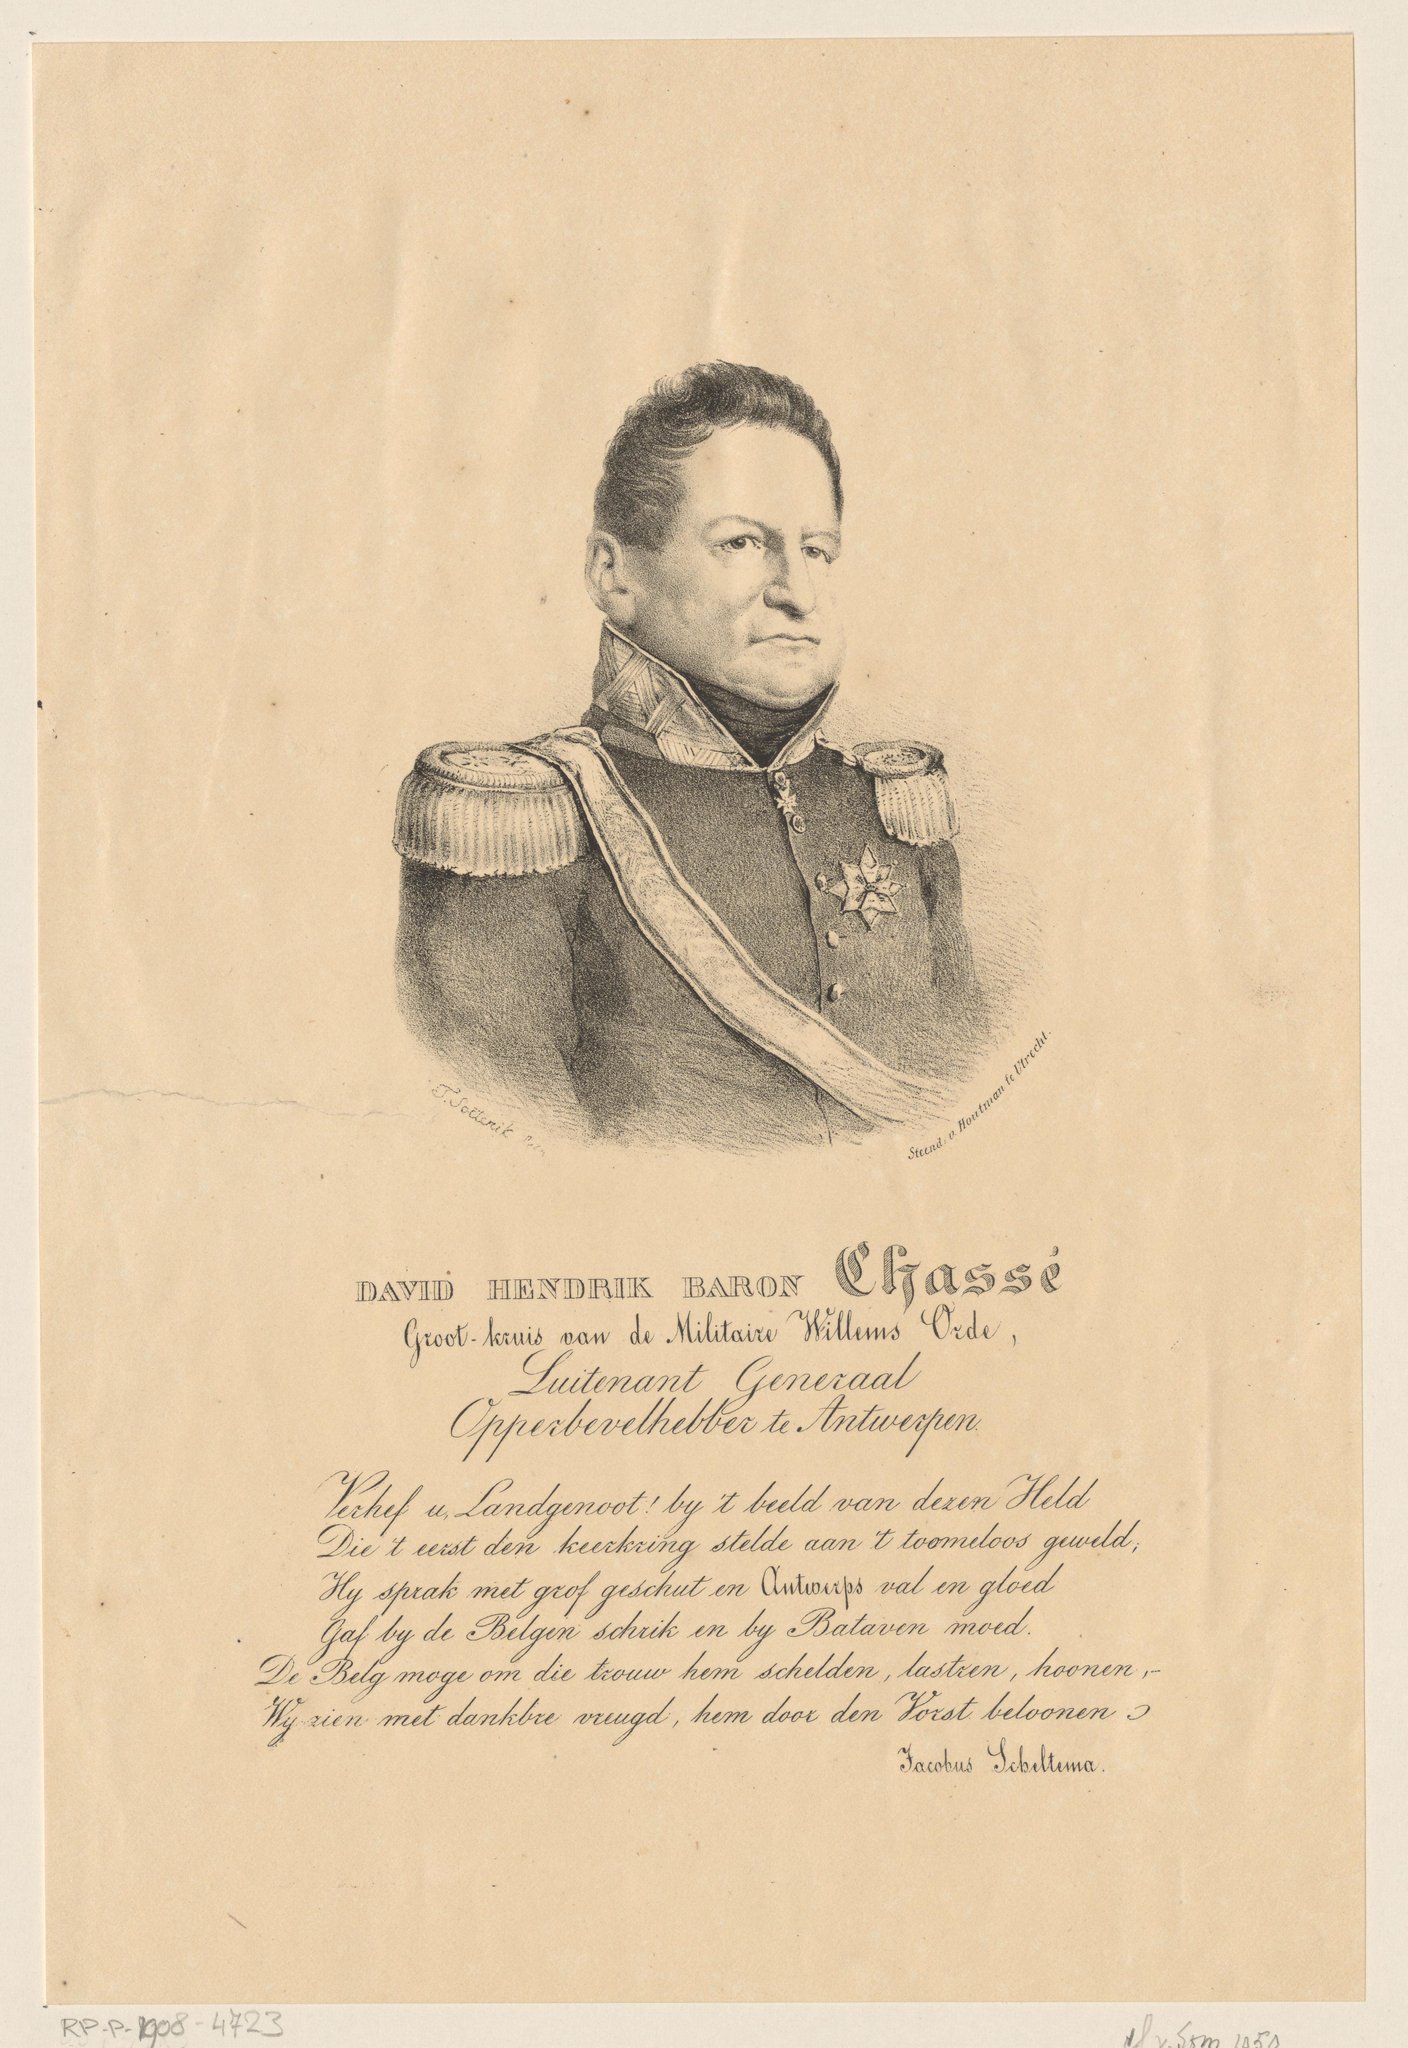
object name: print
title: Portret van David Hendrik baron Chassé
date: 1828-1843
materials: paper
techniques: lithograph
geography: utrecht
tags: david hendrik baron chassé, commander-in-chief, general, marshal, historical persons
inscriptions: collector's mark: Lugt 2282